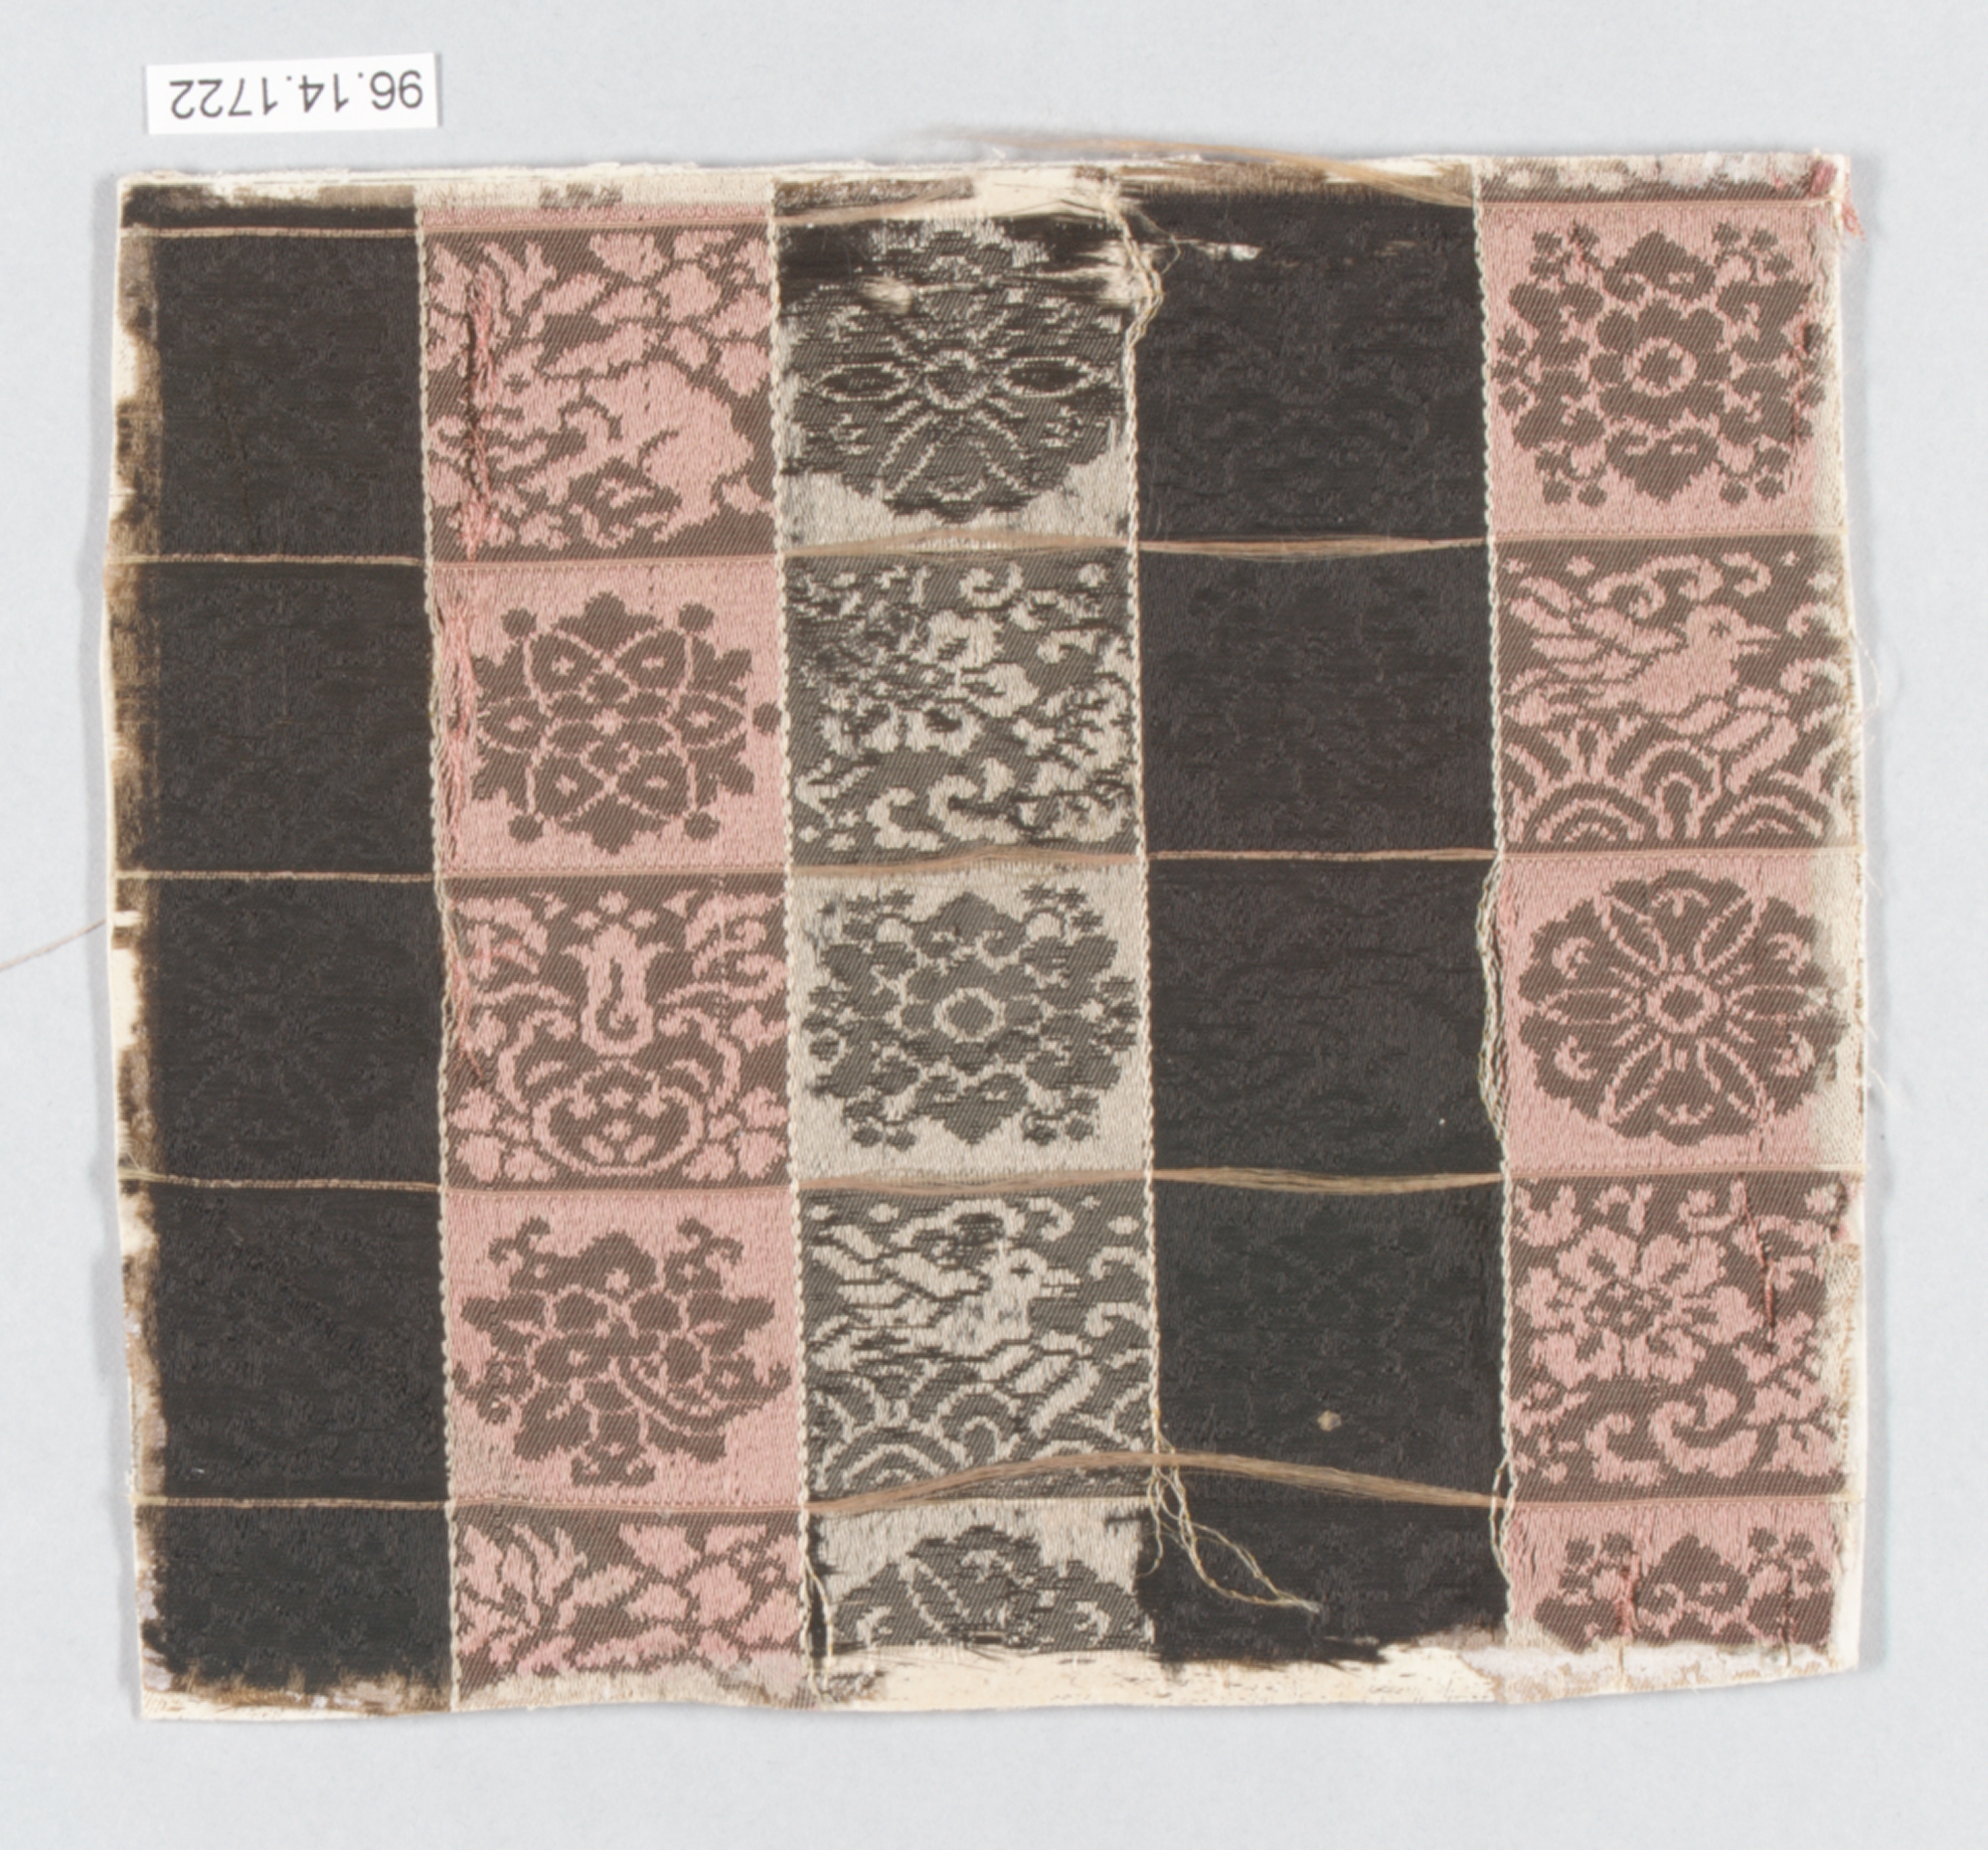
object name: piece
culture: japanese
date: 1701-1900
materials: silk